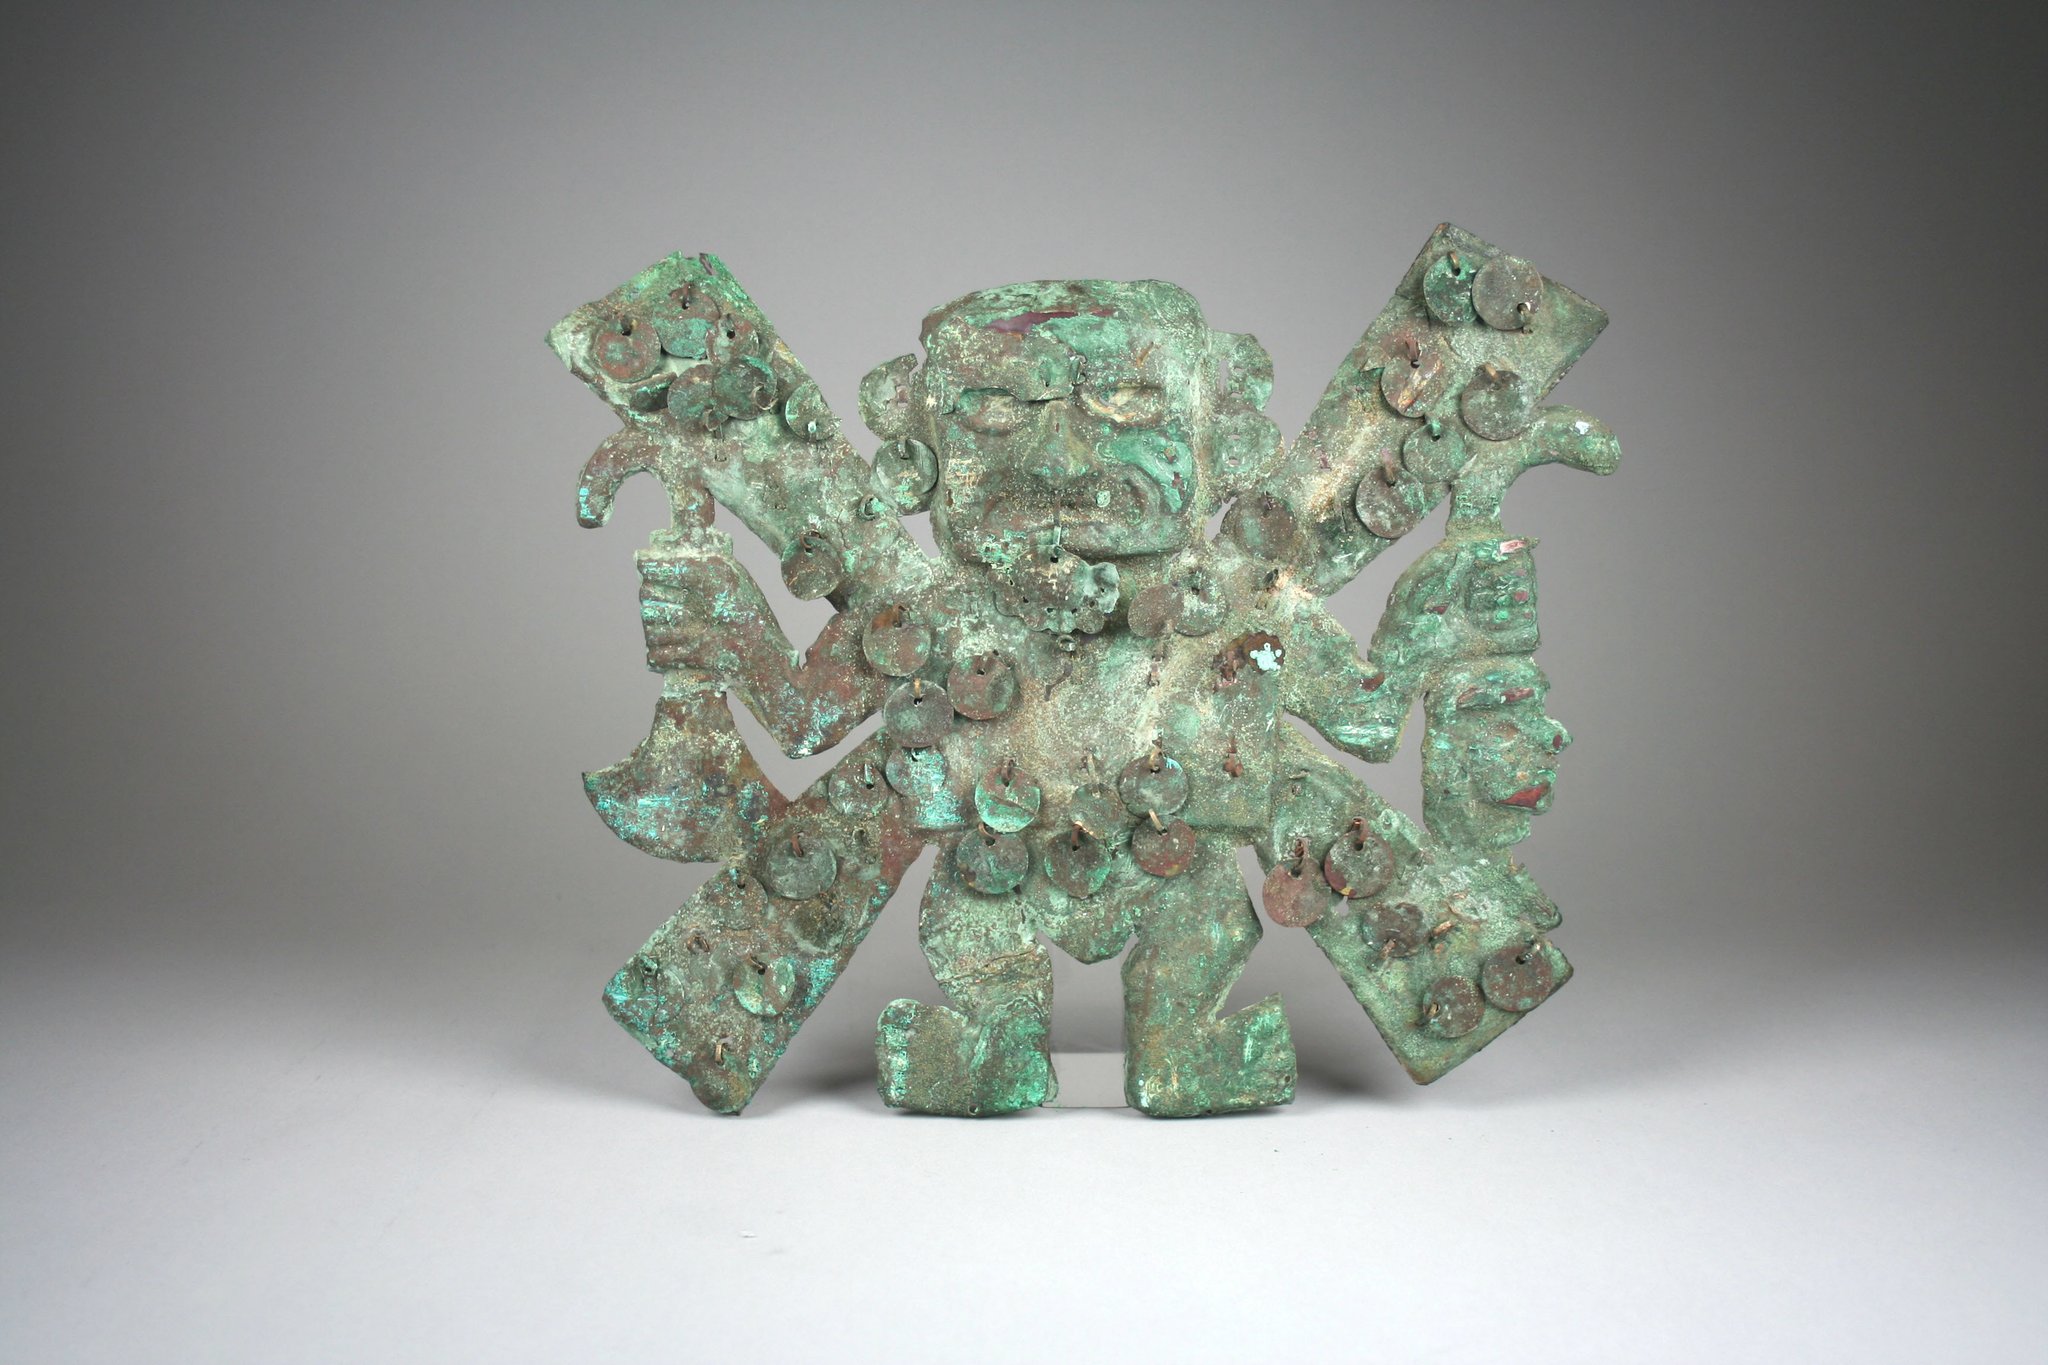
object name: ornament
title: Figure Ornament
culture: moche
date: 501-700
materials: metal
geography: peru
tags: human figures